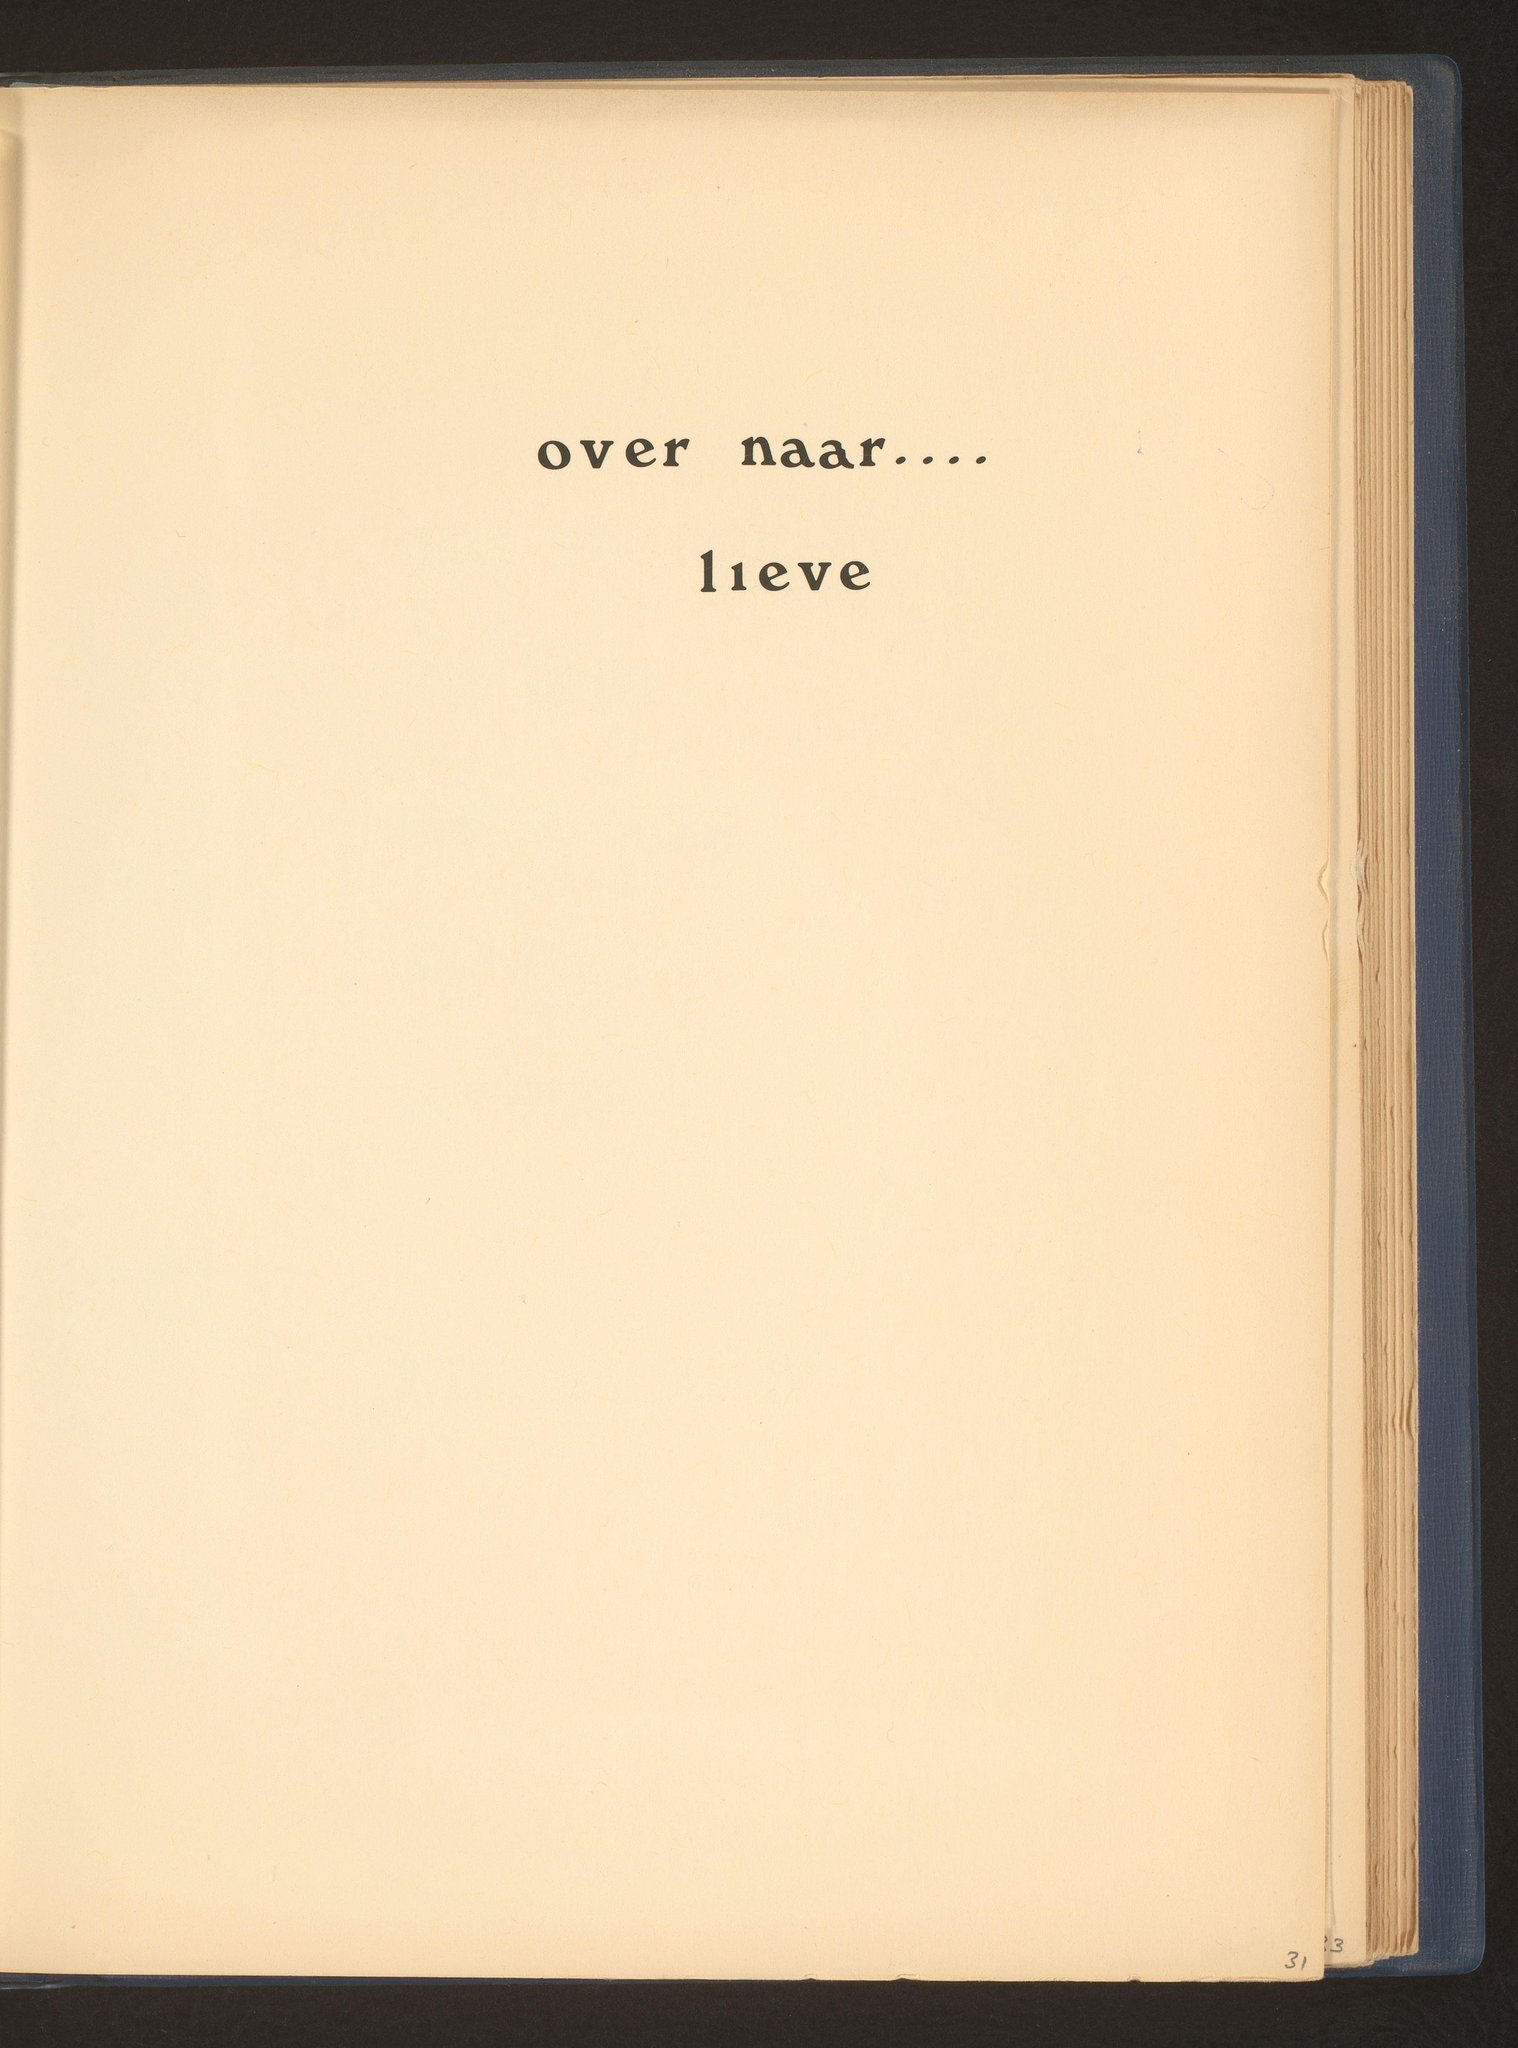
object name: album leaf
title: over naar ... lieve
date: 1971-1972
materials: paper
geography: the hague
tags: the hague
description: Albumblad met opschrift in wrijfletters, verwijzend naar de naam van de voorstelling 'Lieve Neef - Lieve Nicht'. Onderdeel van het fotoalbum van cabaretvoorstellingen COC 1968-1974, afdeling Den Haag.